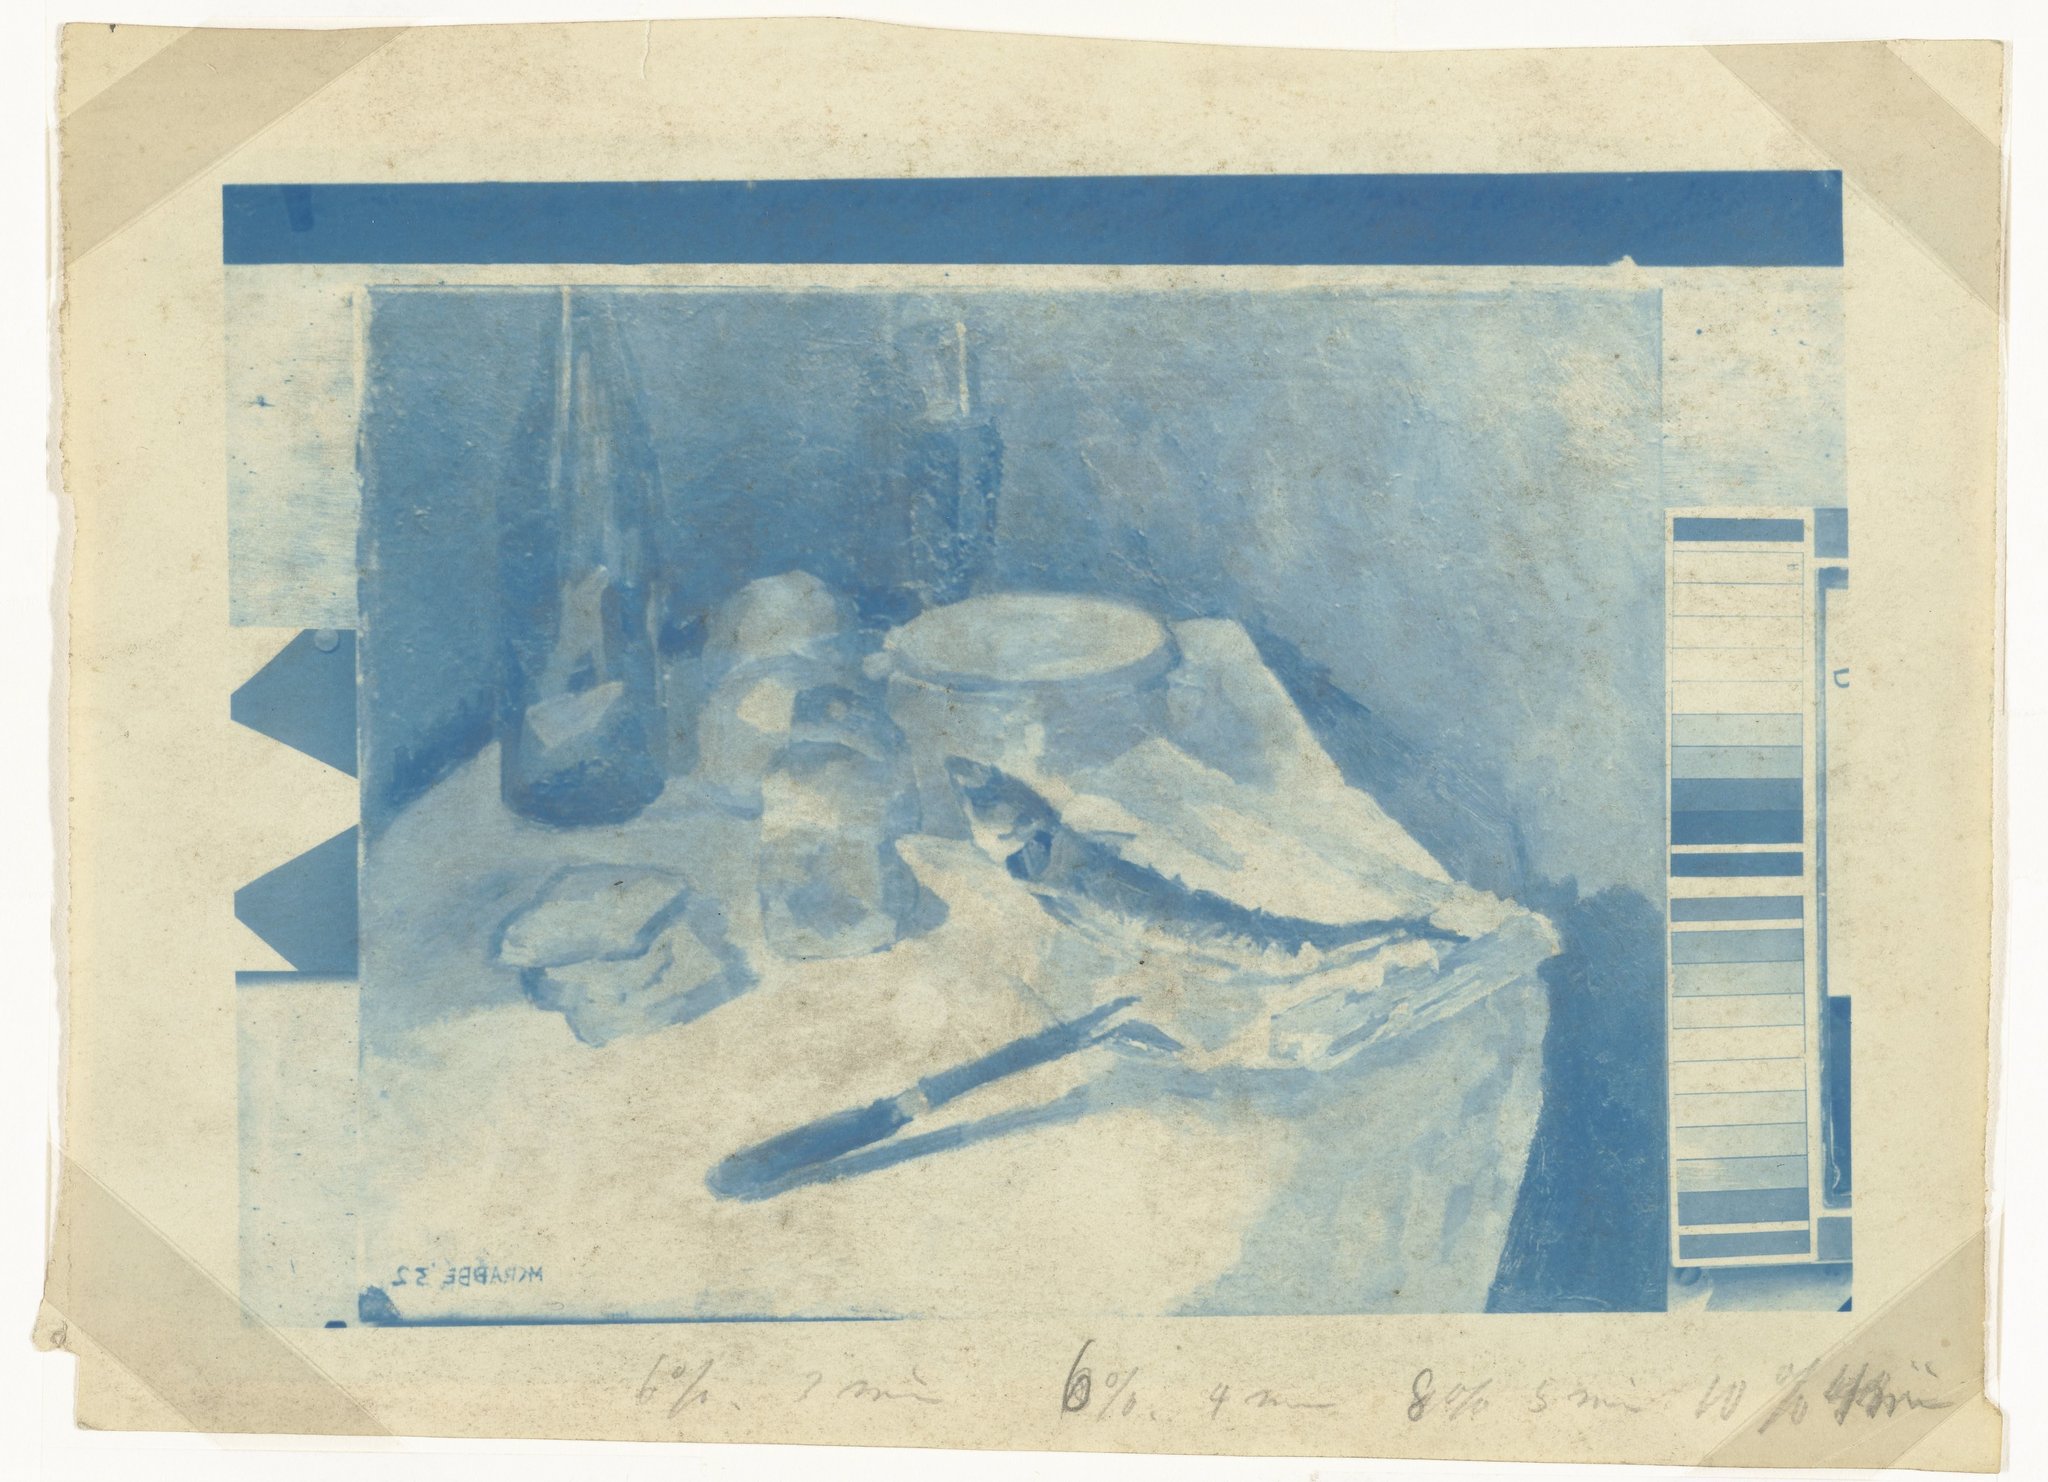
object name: photograph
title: Stilleven door schilder Krabbé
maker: jacob merkelbach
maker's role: fotograaf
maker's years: 1877-1942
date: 1925-1930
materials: paper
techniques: carbro process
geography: amsterdam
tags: still life of related objects